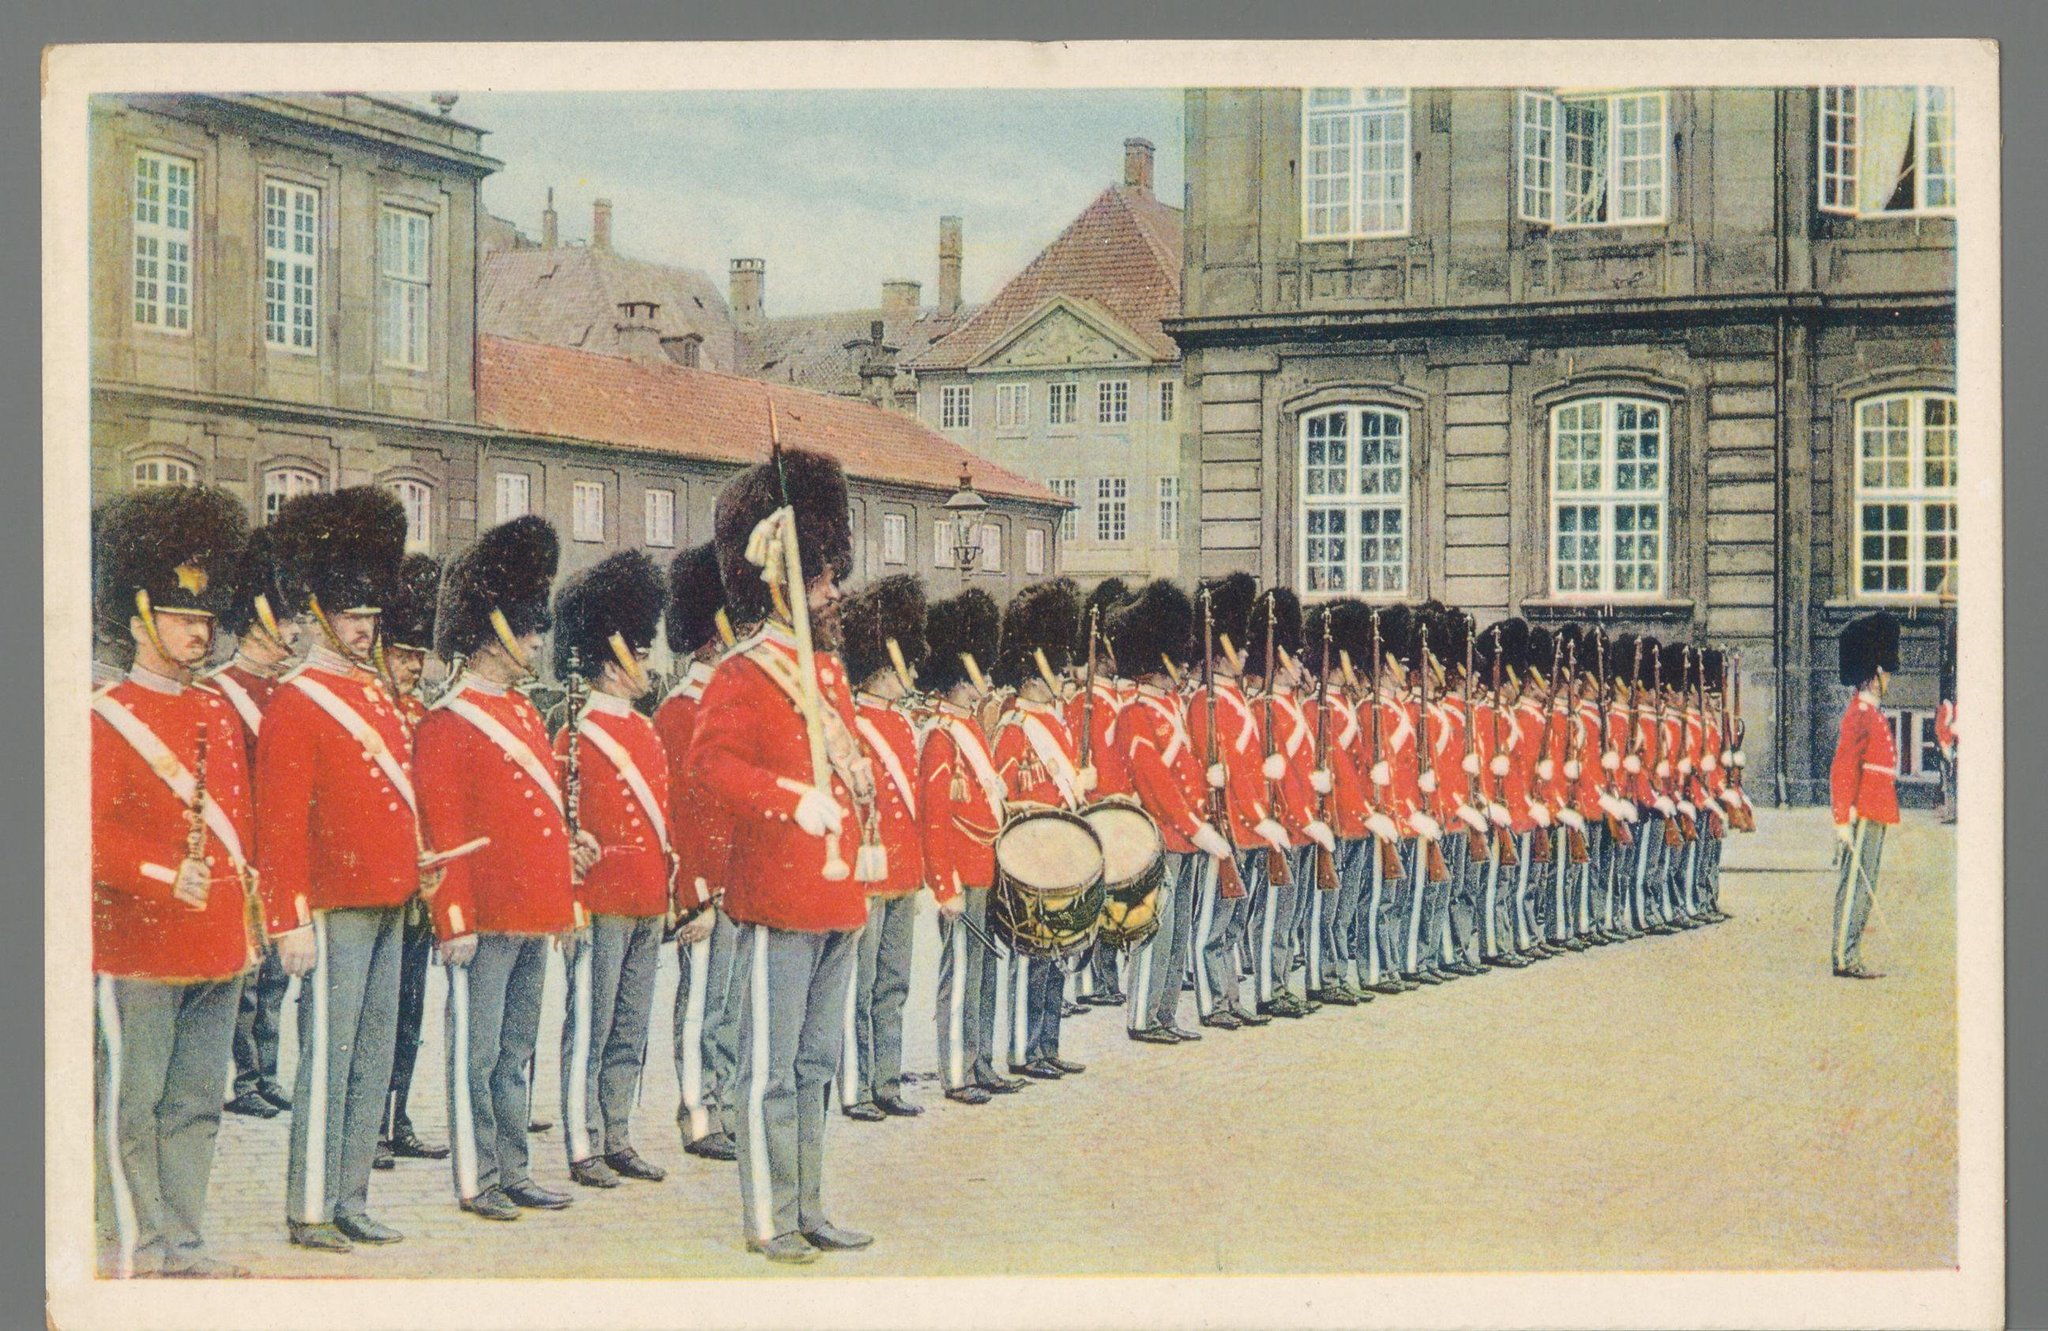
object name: photomechanical print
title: København. Vagtparaden paa Amalienborg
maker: Anonymous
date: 1906-1920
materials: cardboard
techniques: photograph, lithograph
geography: copenhagen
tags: military parade, pageant, inner court of palace or 'hôtel'